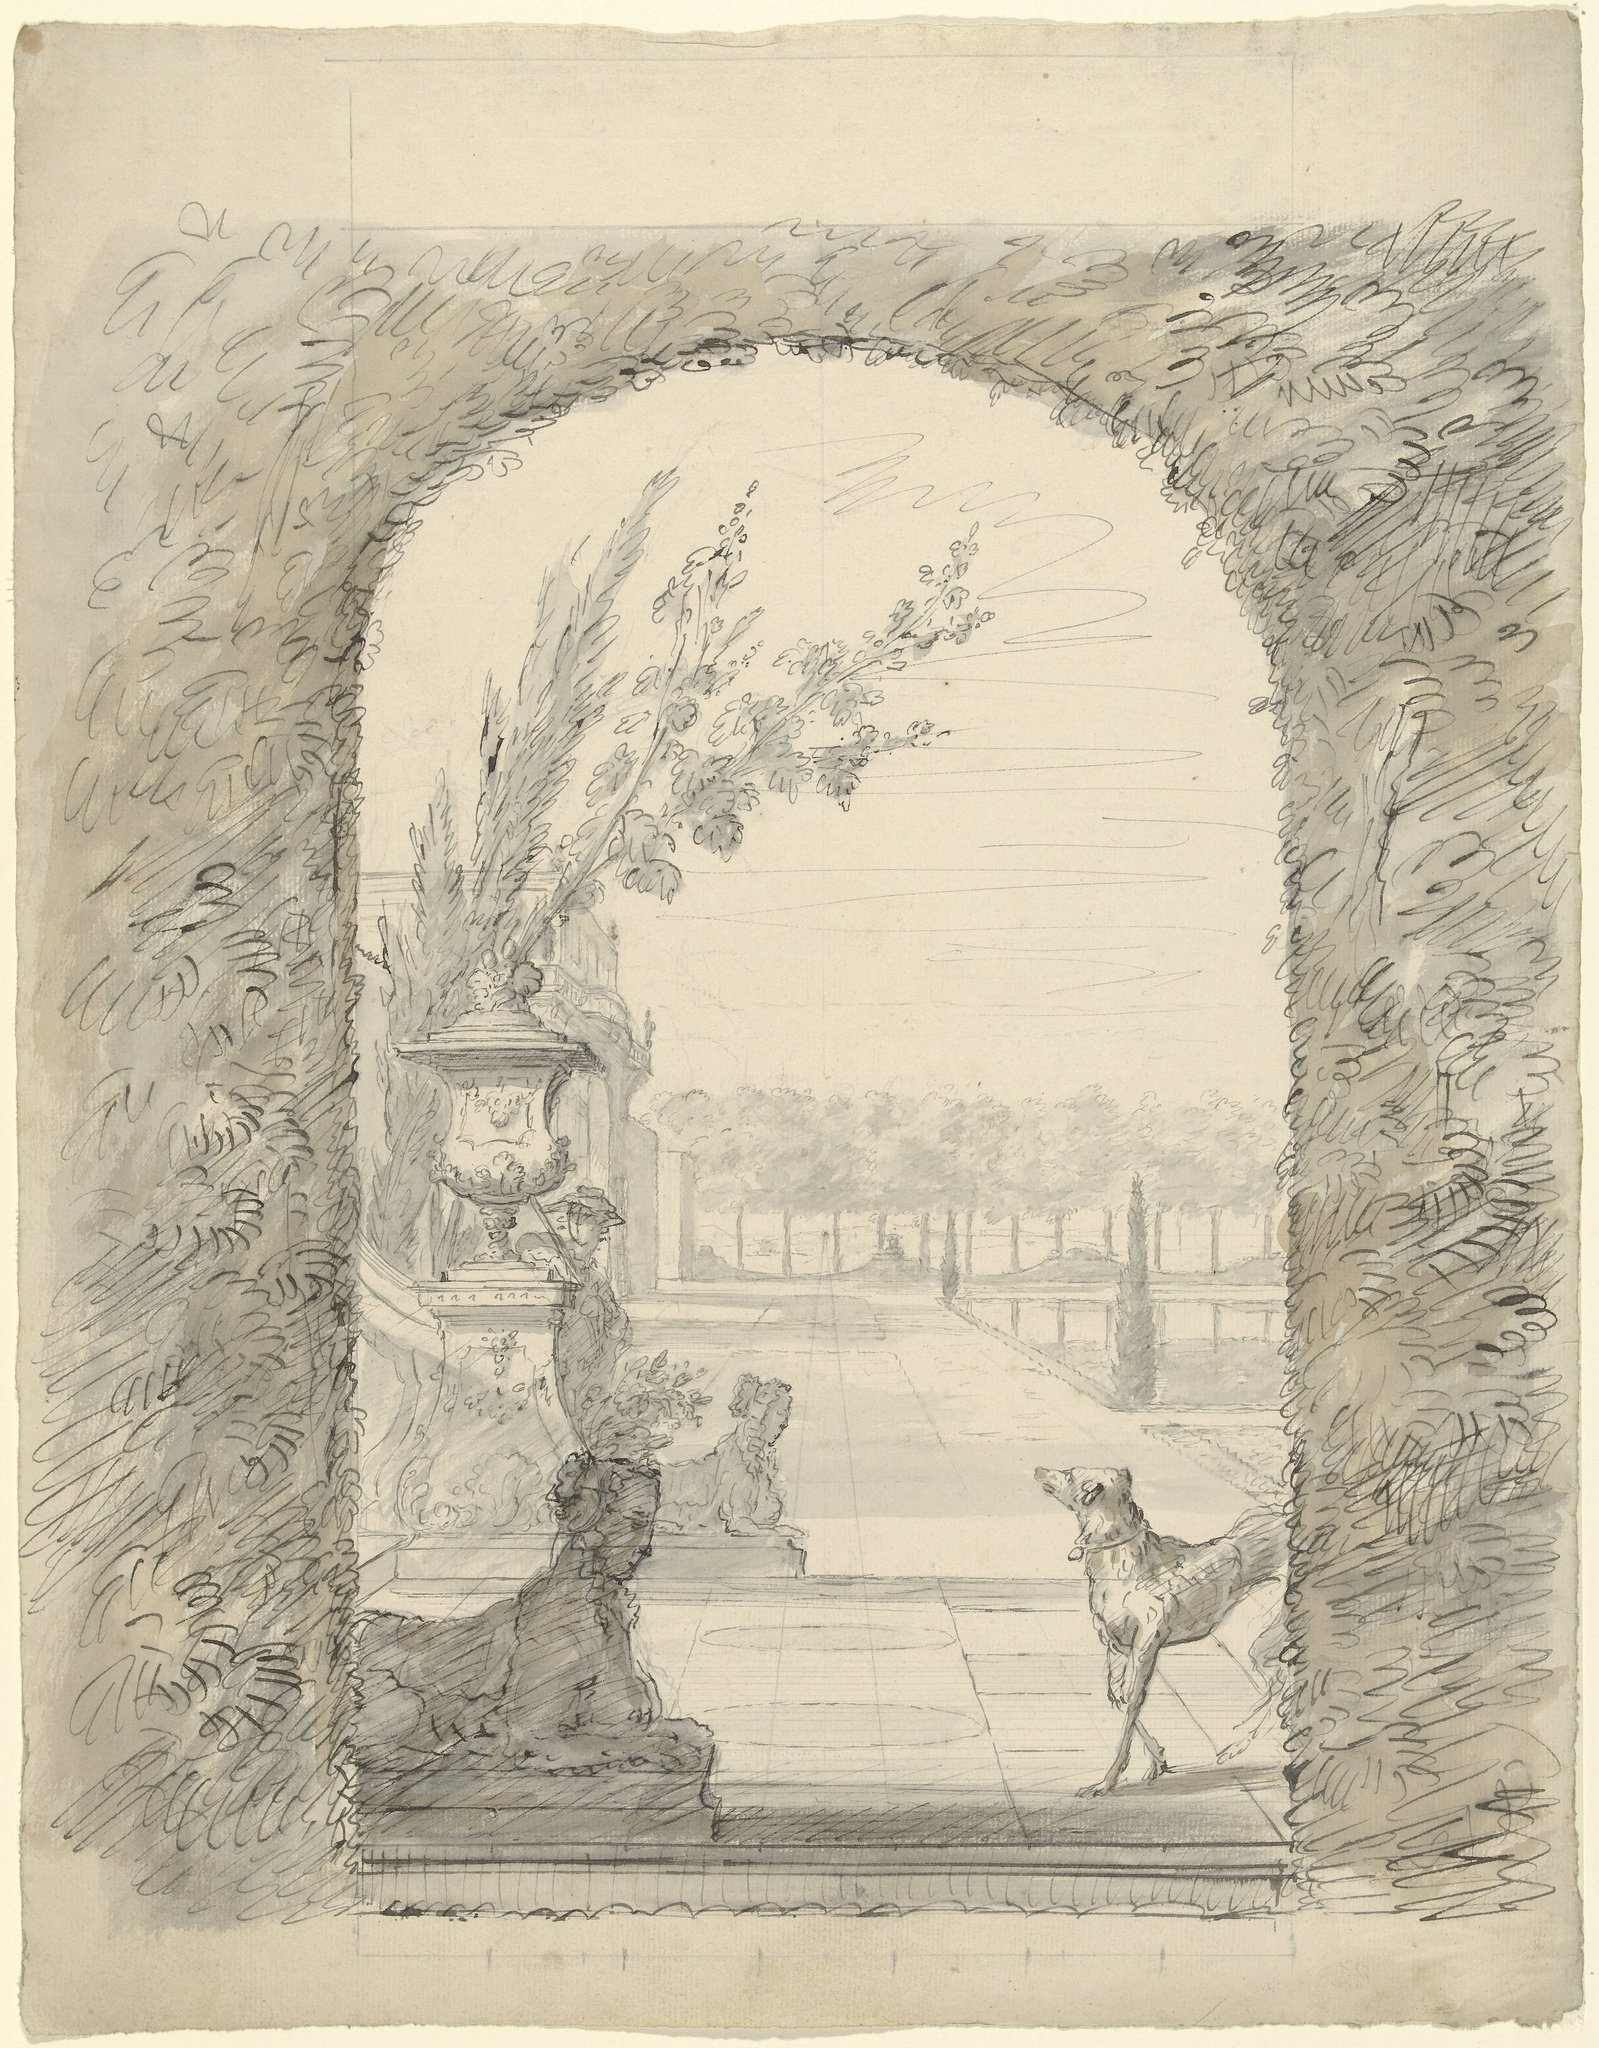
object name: drawing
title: Ontwerp voor een kamerbeschildering met gezicht door een geschoren haag over een terras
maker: dionys van nijmegen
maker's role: draughtsman, painter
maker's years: 1705-1798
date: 1715-1798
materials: ink, paper, pencil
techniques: brush, pen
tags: garden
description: Ontwerp voor een kamerbeschildering met gezicht door een geschoren haag over een terras met sfinxen in een tuin.